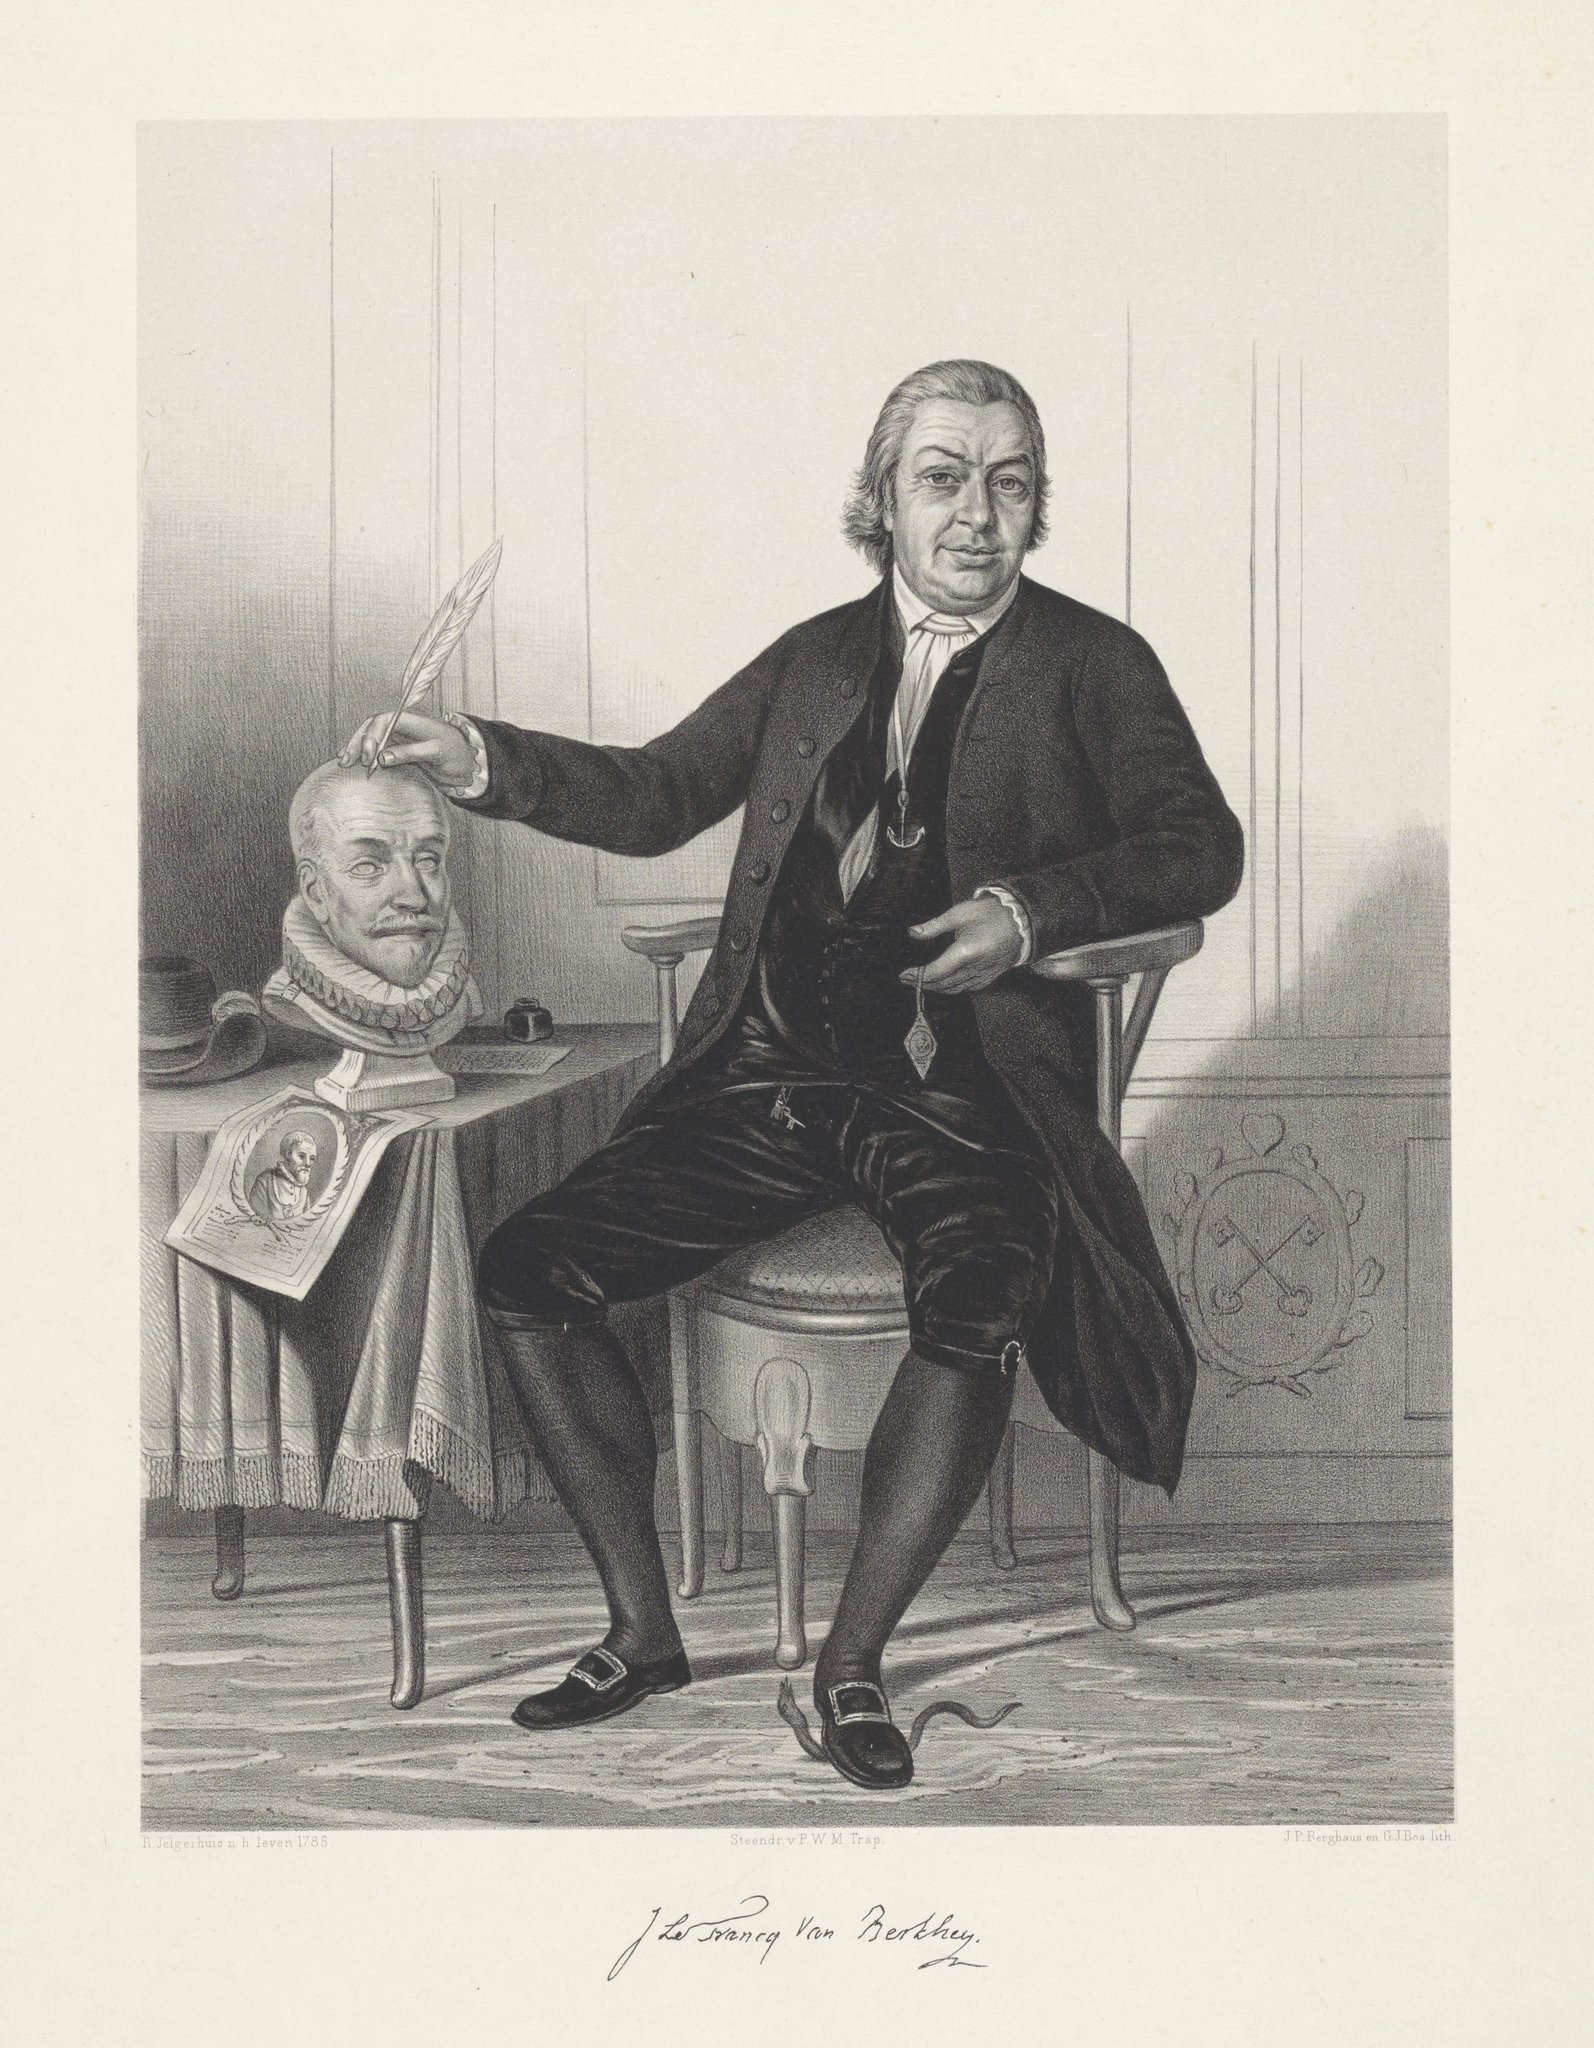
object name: print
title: Portret van Johannes le Francq van Berkhey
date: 1835-1870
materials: paper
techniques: lithograph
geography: leiden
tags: print maker, draughtsman, johannes le francq van berkhey, quill, historical persons, piece of sculpture, reproduction of a piece of sculpture, single printed leaf: broadsheet, leaflet, snakes (+ animals used symbolically), leiden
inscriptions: collector's mark: Lugt 2228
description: De geportretteerde zit op een stoel. Op de tafel een borstbeeld van Willem de Zwijger en een prent met het portret van Pieter Adriaansz. van der Werff, burgemeester van Leiden tijdens de 80-jarige oorlog. Achter hem een wandbetimmering met onderin een ovaal waarbinnen twee gekruisde sleutels uit het stadswapen van Leiden. Op tafel liggen verder een hoed met pluim, inktpotje en een blad papier. De geportretteerde draagt een donkere kniebroek en kousen en schoenen met gespen. In zijn rechterhand die op het borstbeeld rust heeft hij een ganzenveer, in linkerhand een ruitvormig klein object. Om zijn nek een ketting met een hanger in de vorm van een anker. Onder zijn linkervoet kronkelt een adder. Onder het portret de signatuur van de geportretteerde.